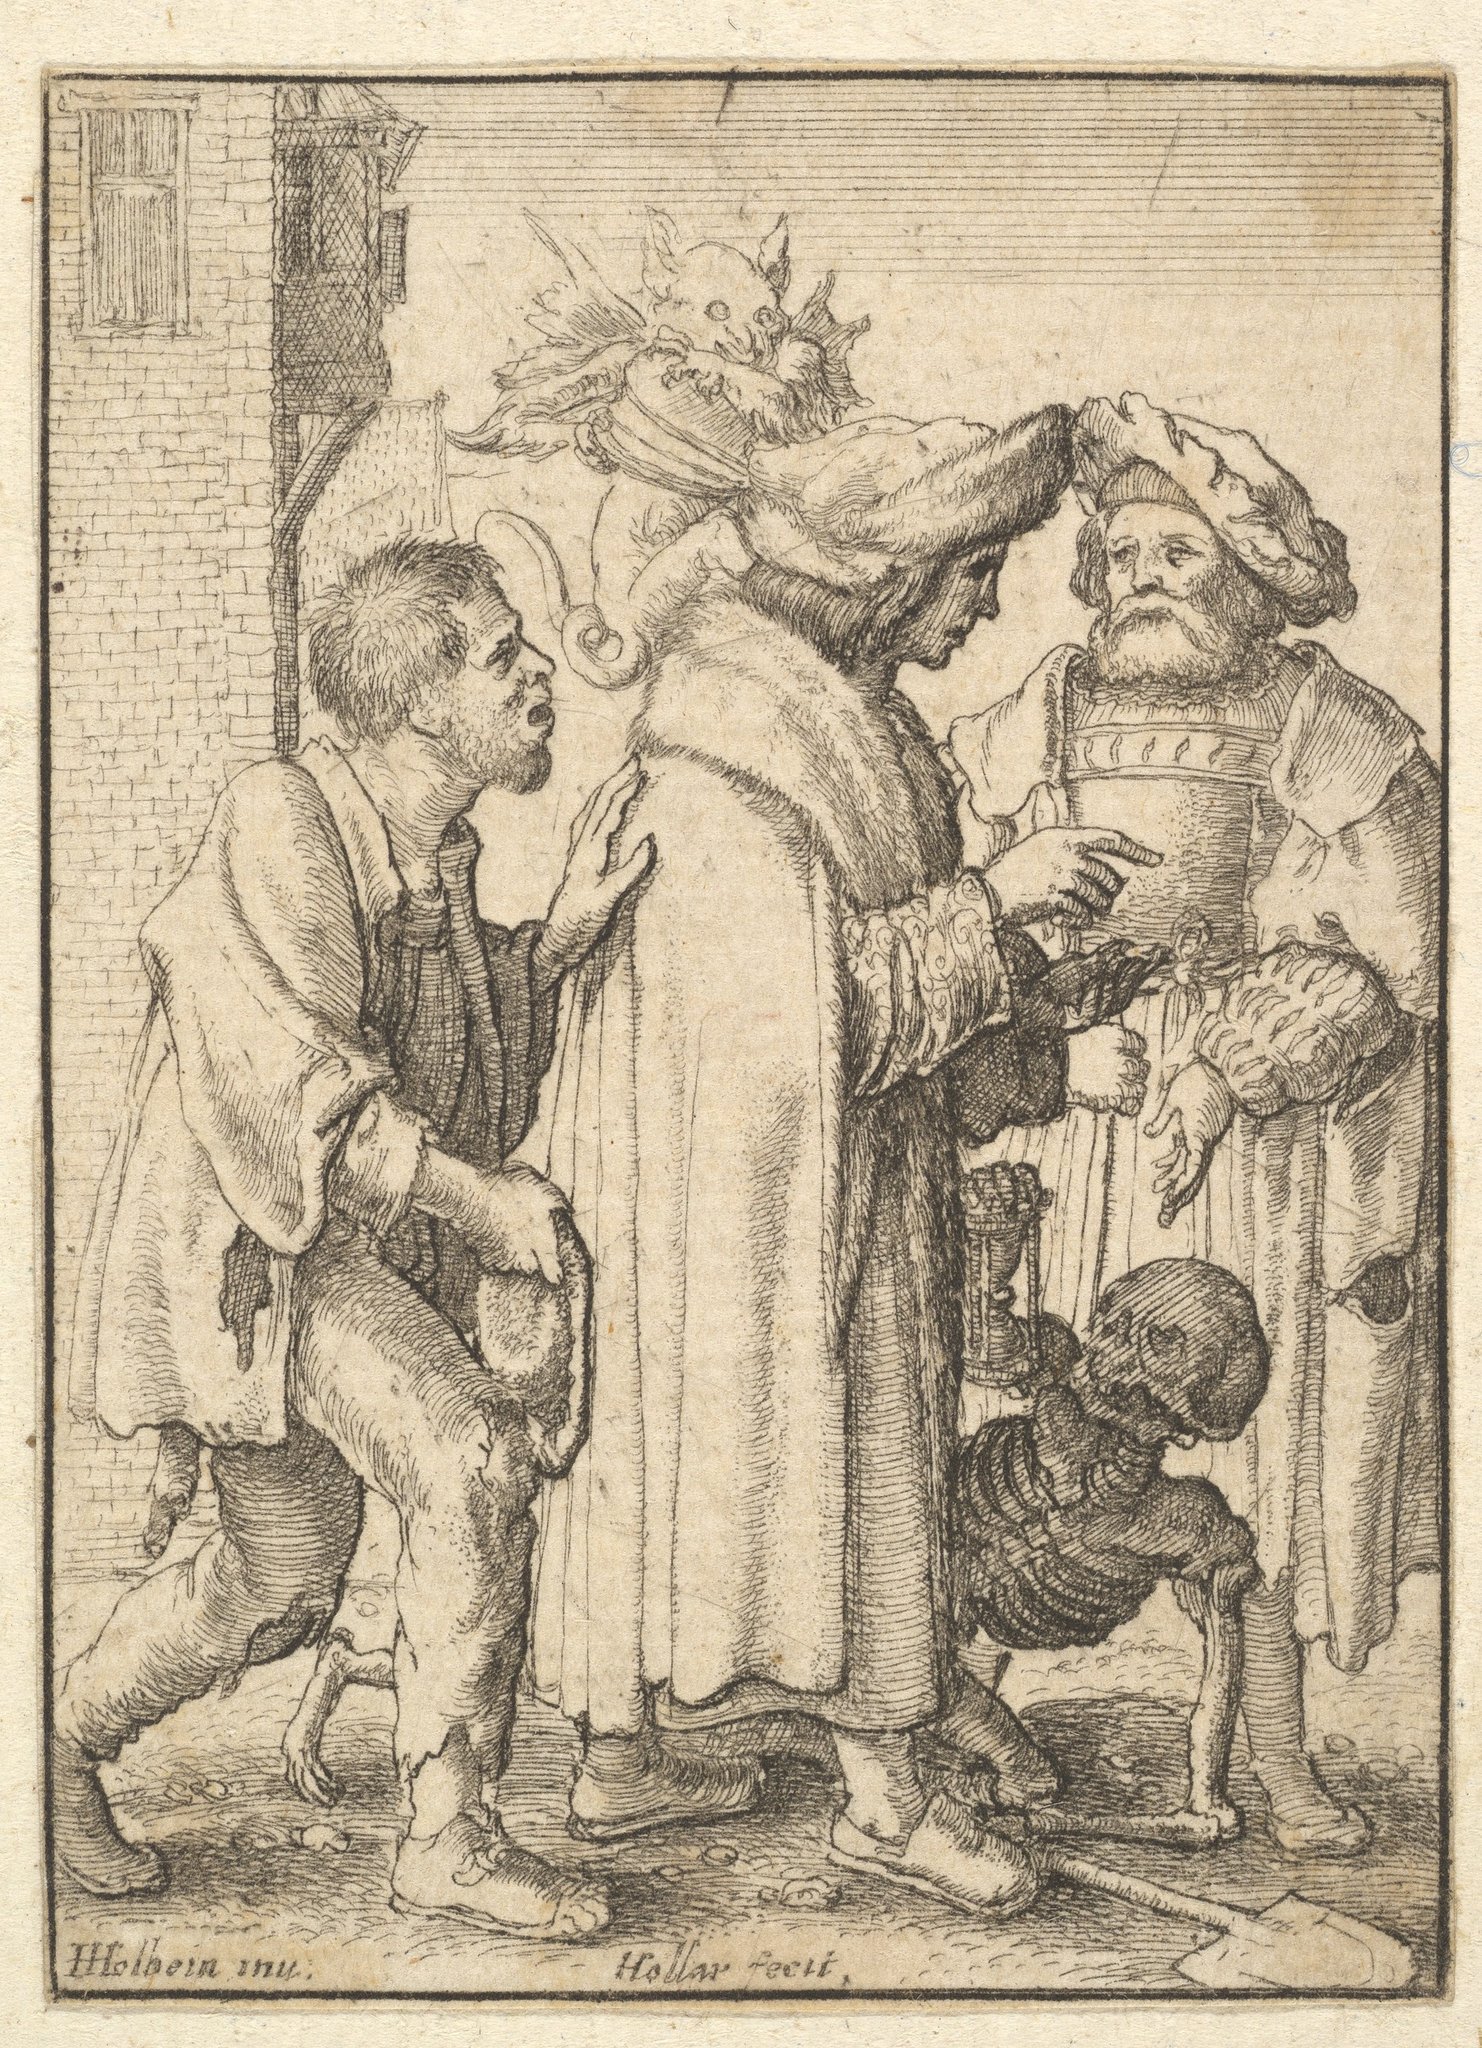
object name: print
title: Rich Man, from the Dance of Death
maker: wenceslaus hollar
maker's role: artist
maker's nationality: bohemian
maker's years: 1607-1677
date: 1651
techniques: etching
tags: skeletons,men,devil